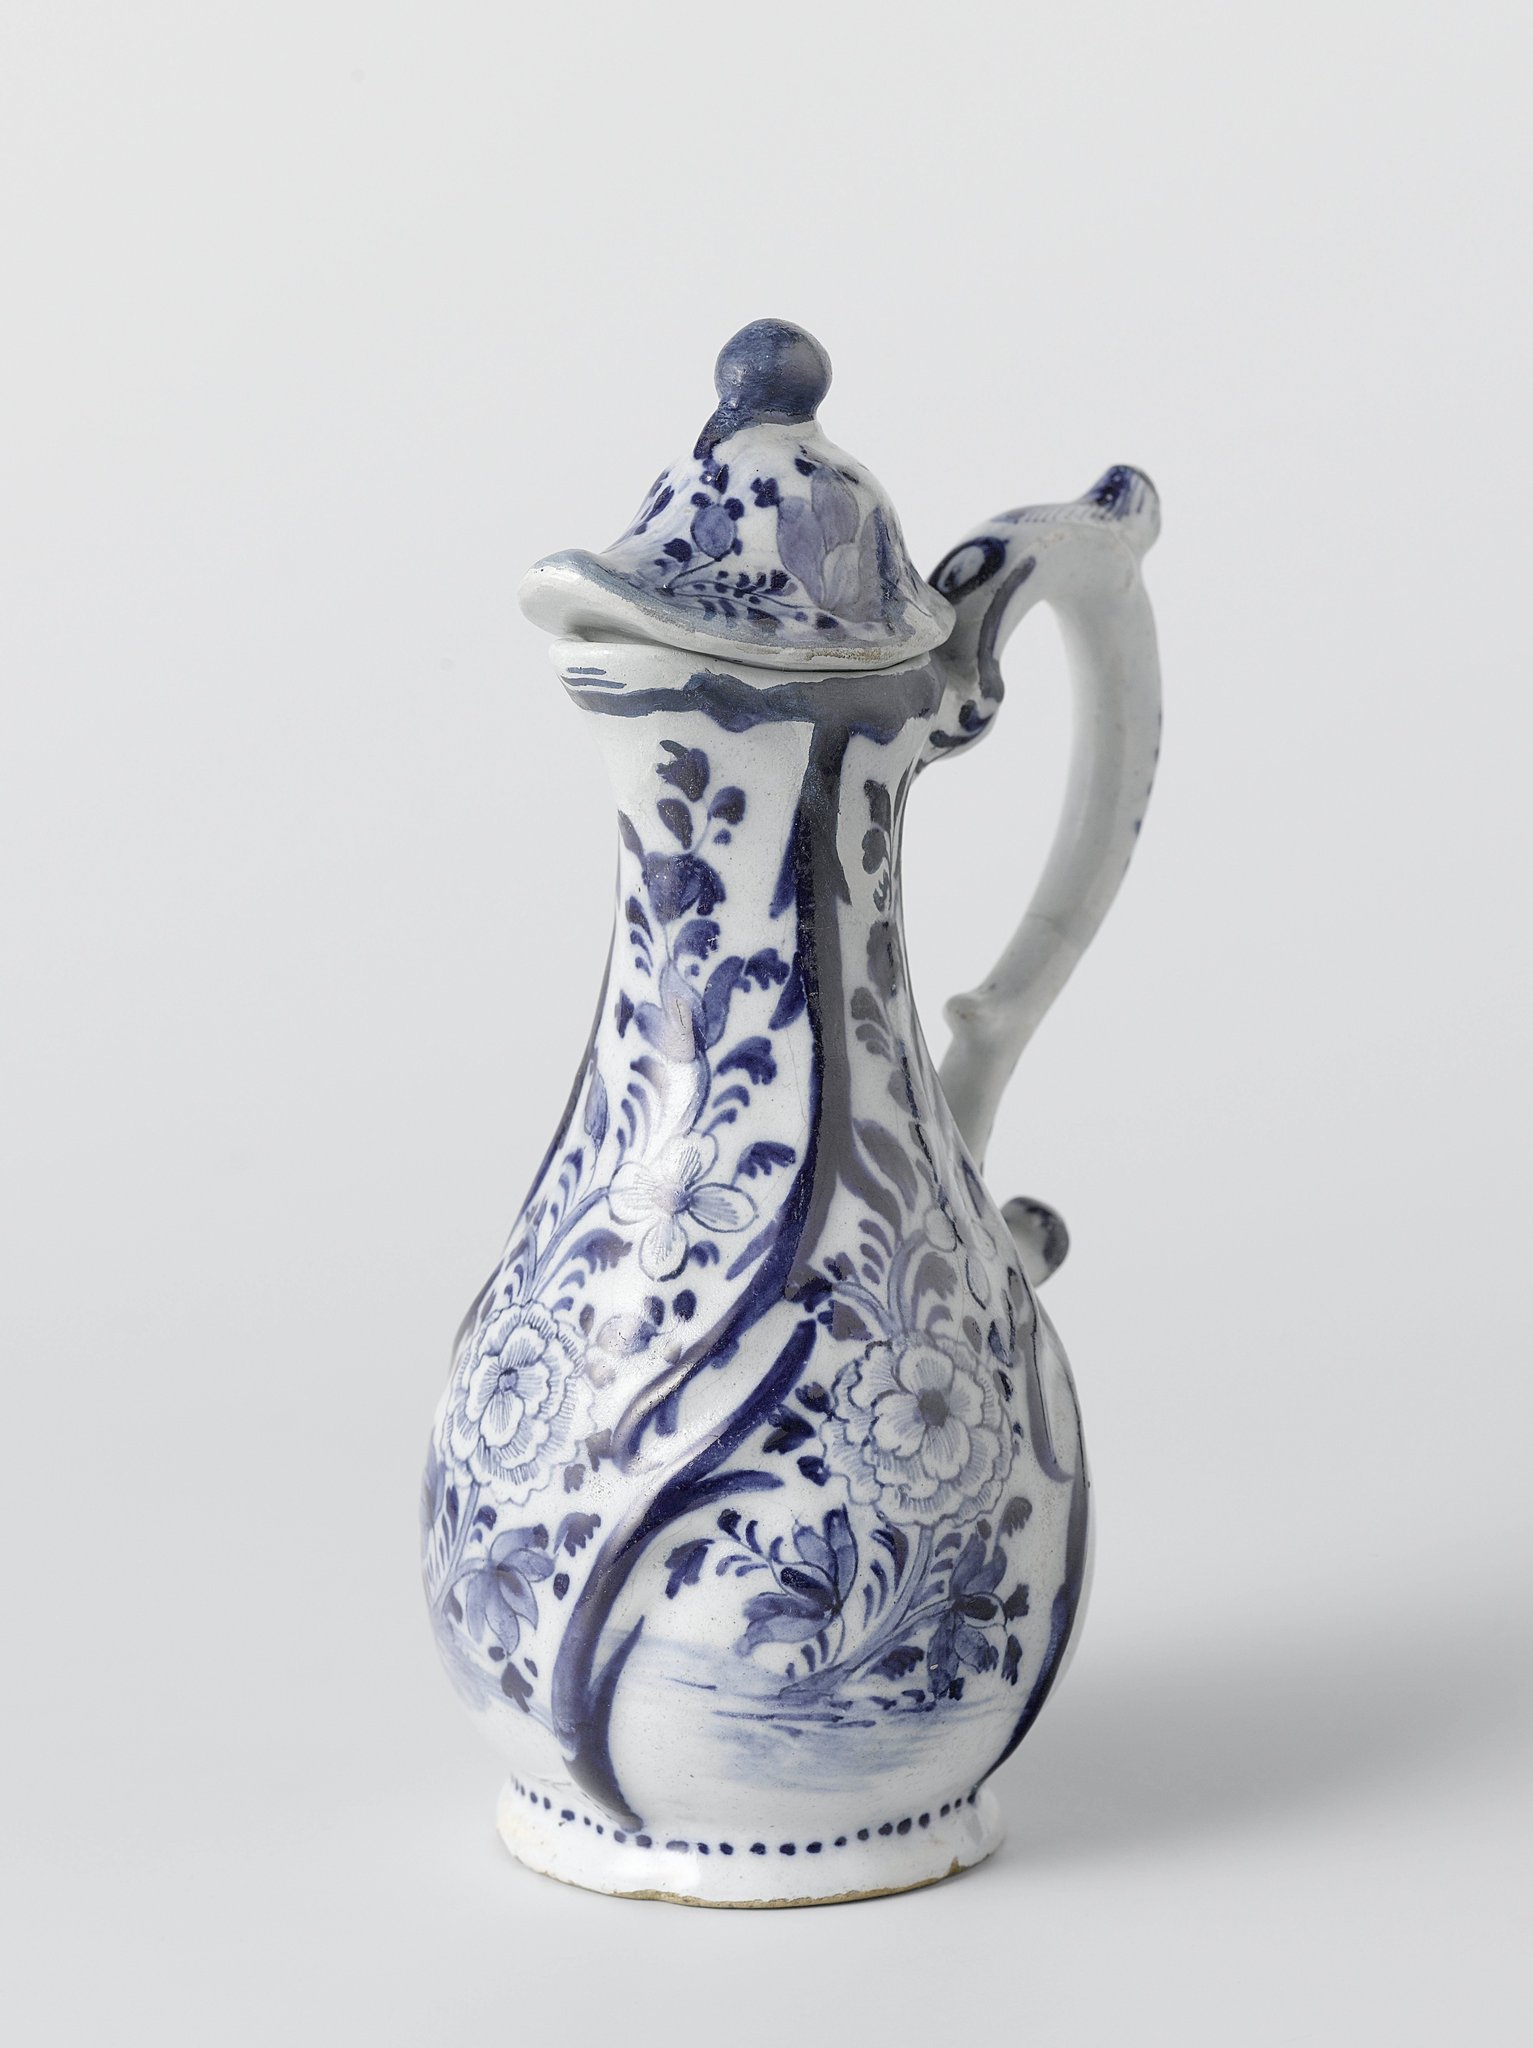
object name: ewer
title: Kan met deksel van blauw beschilderde faience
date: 1753-1771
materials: faience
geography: delft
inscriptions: mark: ‘VB (ineen)’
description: Kan met deksel van blauw beschilderde faience.